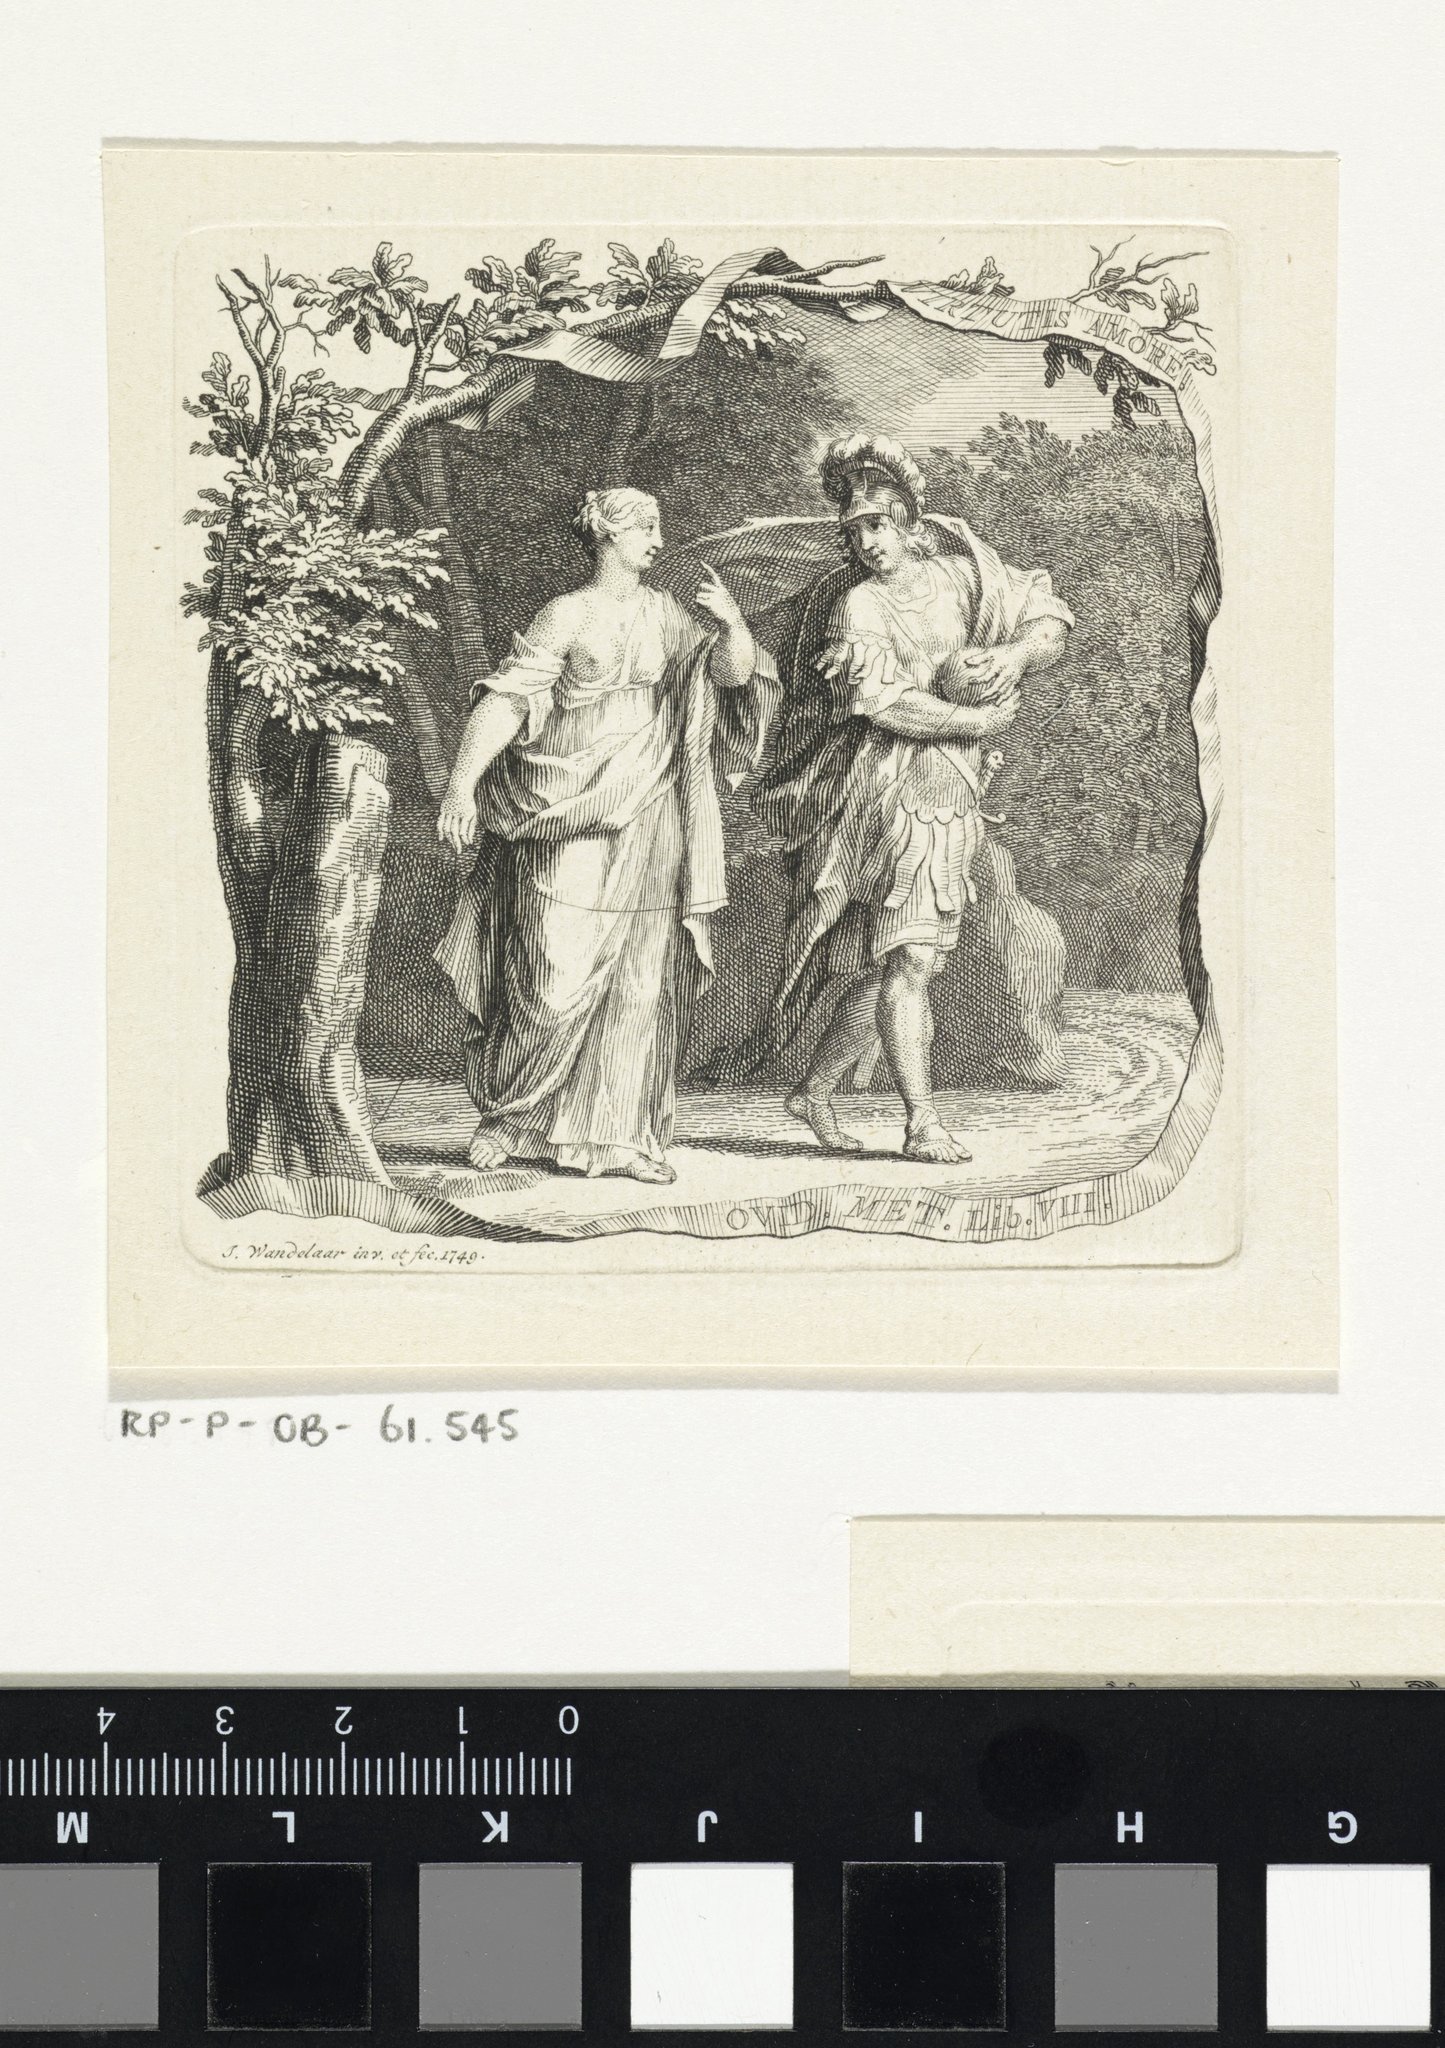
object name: print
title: Vignet met Theseus en Ariadne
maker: jan wandelaar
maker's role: draughtsman, print maker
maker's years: 1690-1759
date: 1749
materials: paper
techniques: engraving, etching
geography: northern netherlands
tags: ariadne gives theseus a ball of thread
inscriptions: collector's mark: Lugt 2228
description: Theseus en Ariadne wandelen door een landschap. Ariadne houdt een draad vast van de bol garen in Theseus' handen. De voorstelling wordt grotendeels door een spreukband omgeven waarop de woorden Virtutis Amore en de verwijzing naar het achtste boek van Ovidius' Metamorfosen, waarin het verhaal staat.